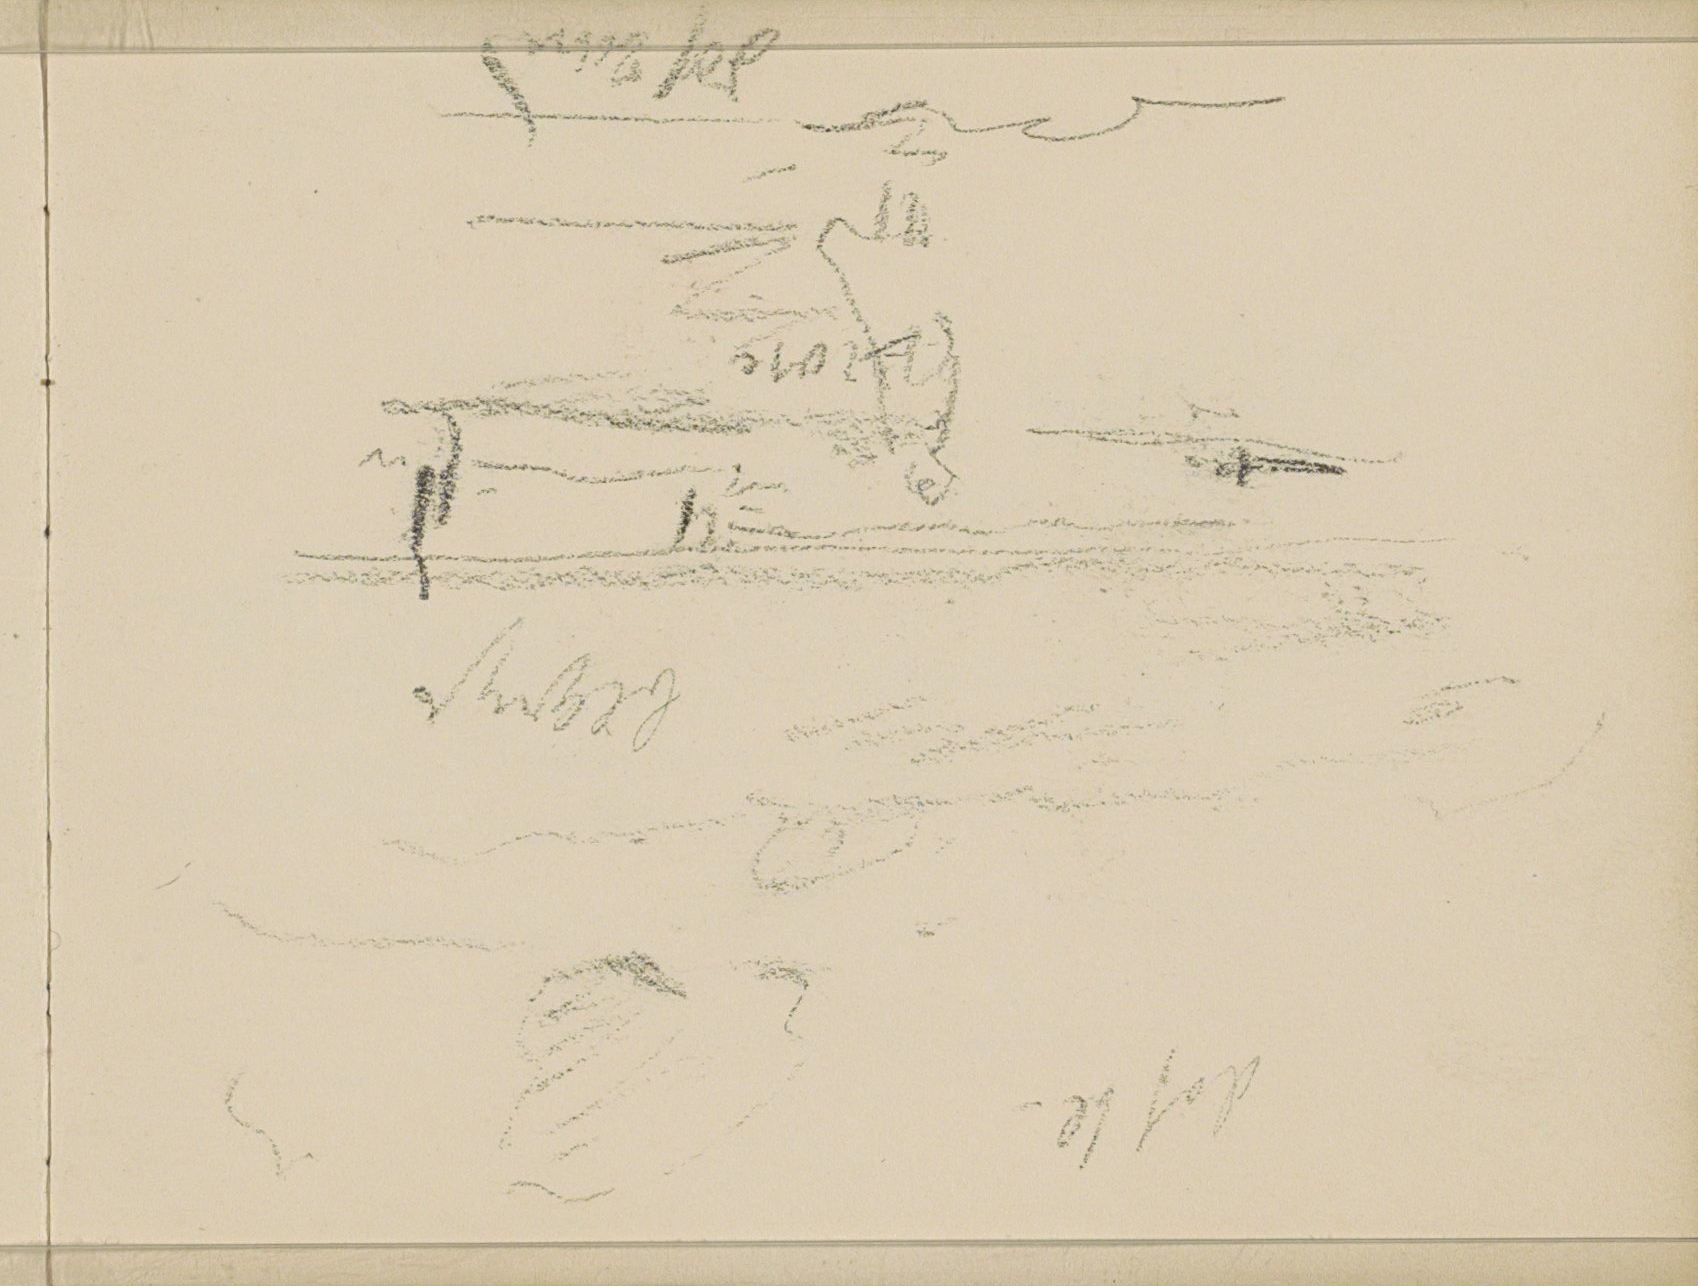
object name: sketchbook leaf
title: Vrouw in een landschap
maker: johan antonie de jonge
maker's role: draughtsman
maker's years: 1864-1927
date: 1881-1927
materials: chalk, paper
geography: south holland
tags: adult woman, landscapes with waters, waterscapes, seascapes (in the temperate zone)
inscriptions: kleurnotitie, handgeschreven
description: Vrouw in een landschap, mogelijk met een kustlijn. Blad 3 recto uit een schetsboek met 34 bladen.